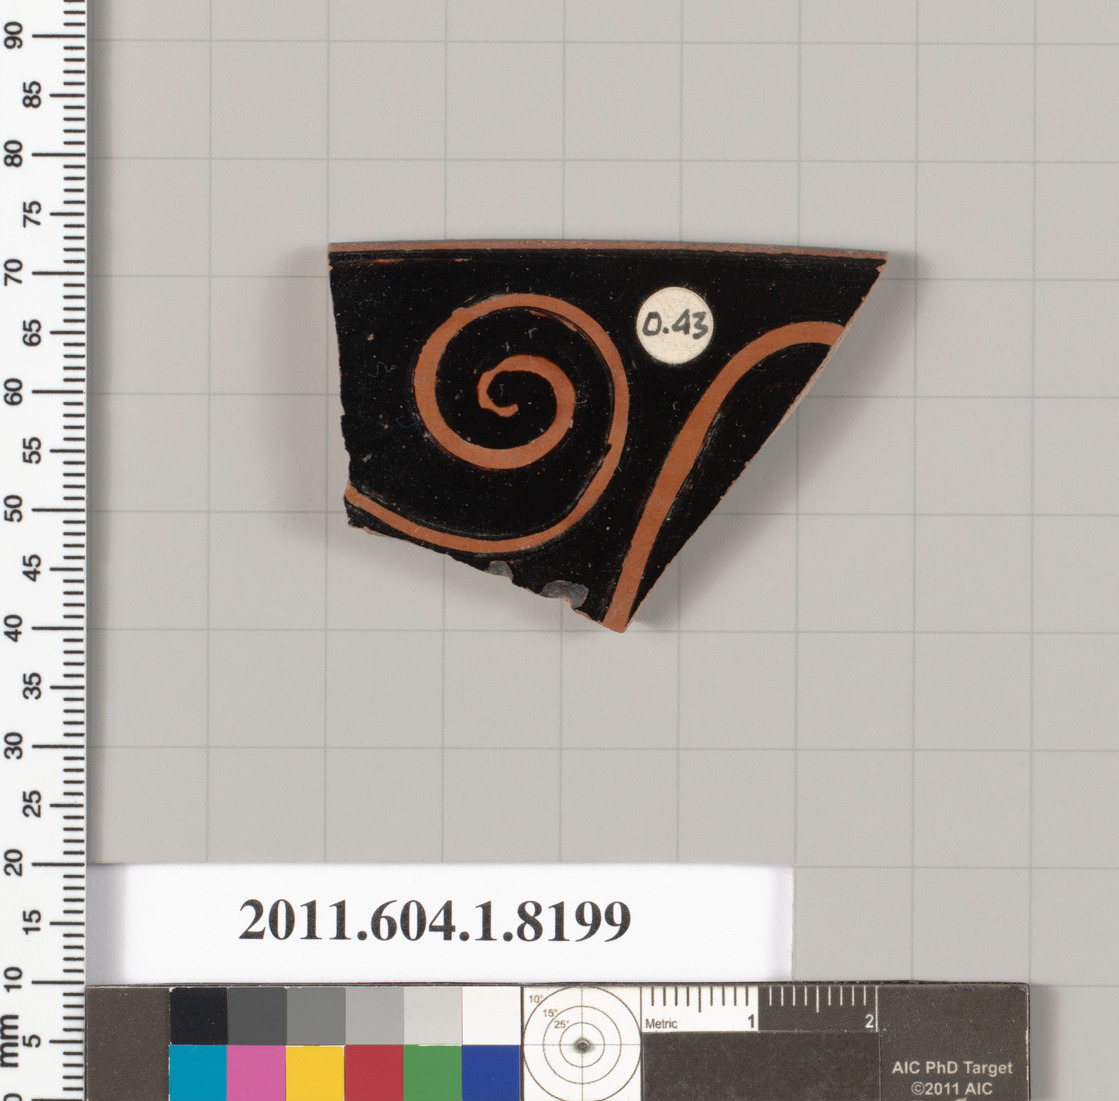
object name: kylix fragment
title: Terracotta rim fragment of a kylix (drinking cup)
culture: greek, attic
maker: phintias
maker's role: artist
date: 520-510 BCE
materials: terracotta